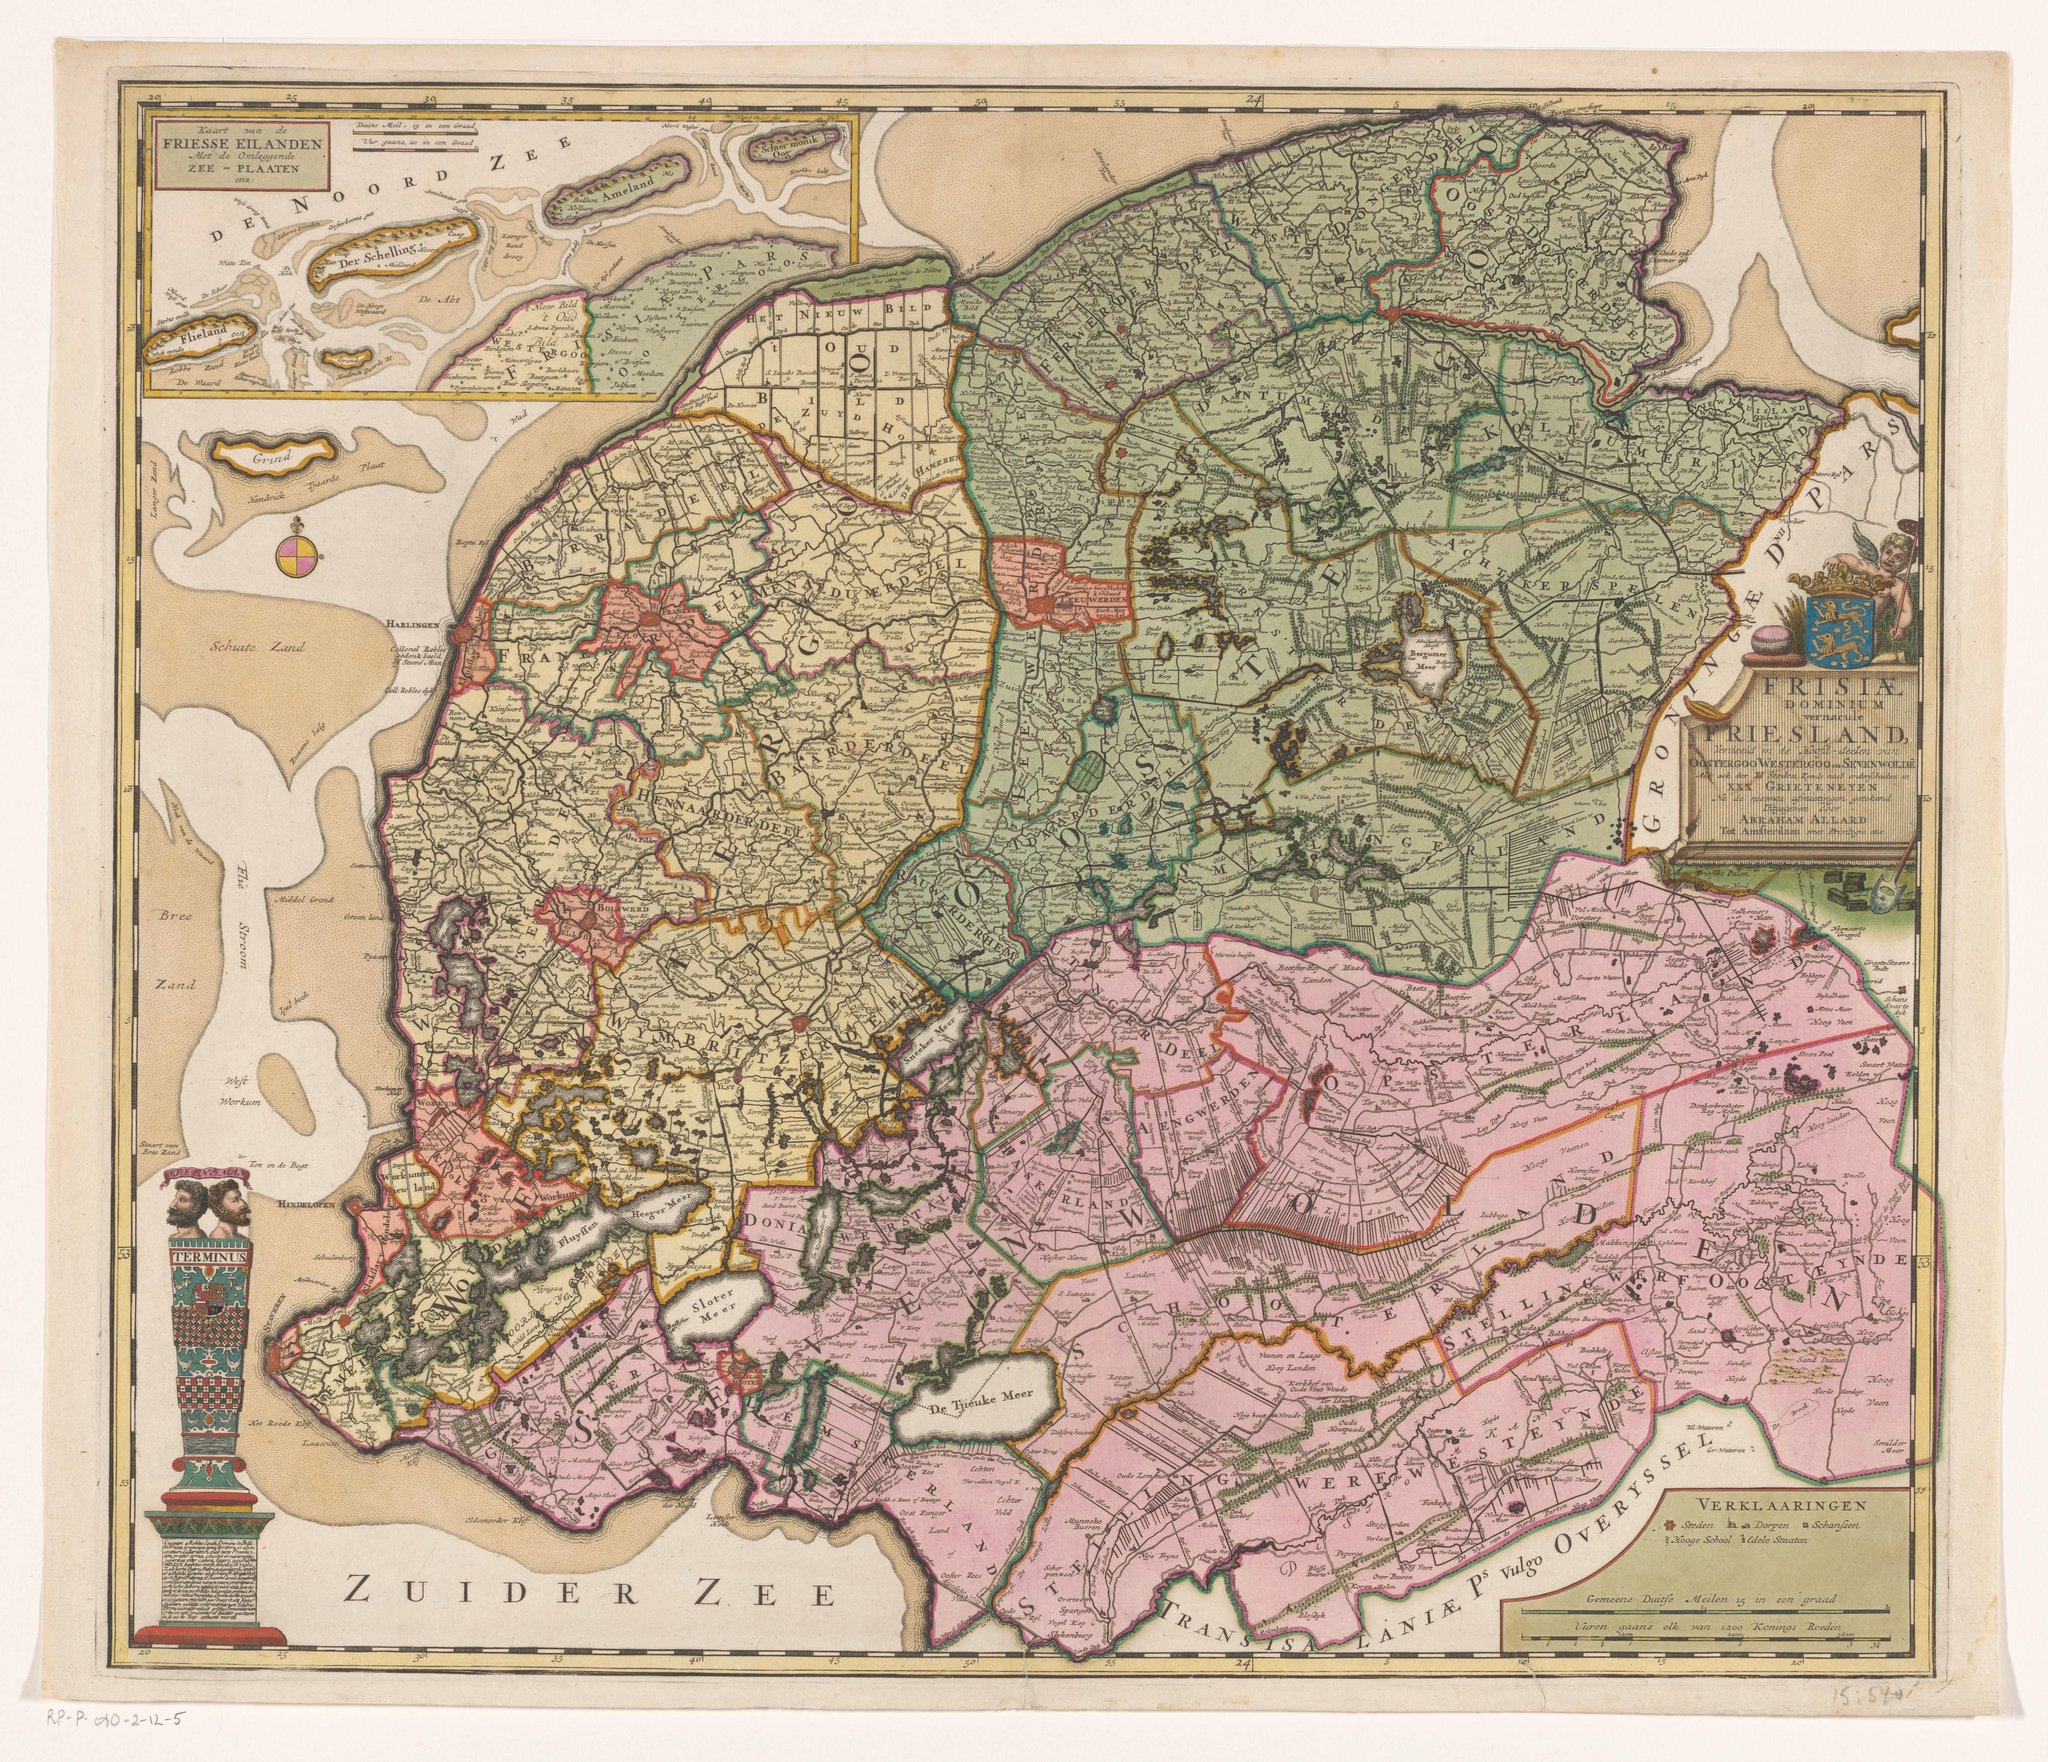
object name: print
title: Frisiae dominium vernacule Friesland (...)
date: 1703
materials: paper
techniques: engraving, etching, hand coloring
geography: amsterdam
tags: coat of arms (as symbol of the state, etc.), maps of separate countries or regions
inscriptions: collector's mark: Lugt 2228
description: Linksboven inzetkaart van Vlieland, Terschelling, Ameland en Schiermonnikoog, met twee schaalstokken: Duitze meil 15 in een graad, Uur gaans 20 in een graad. Linksonder afbeelding van het standbeeld de Stenen Man te Harlingen. Rechtsmidden titelcartouche met daarboven het wapen van Friesland. Rechtsonder legenda en twee schaalstokken: Gemeene Duitse meilen 15 in een graad, Uuren gaans elk van 1200 konings roeden. Gradenverdeling langs de randen.